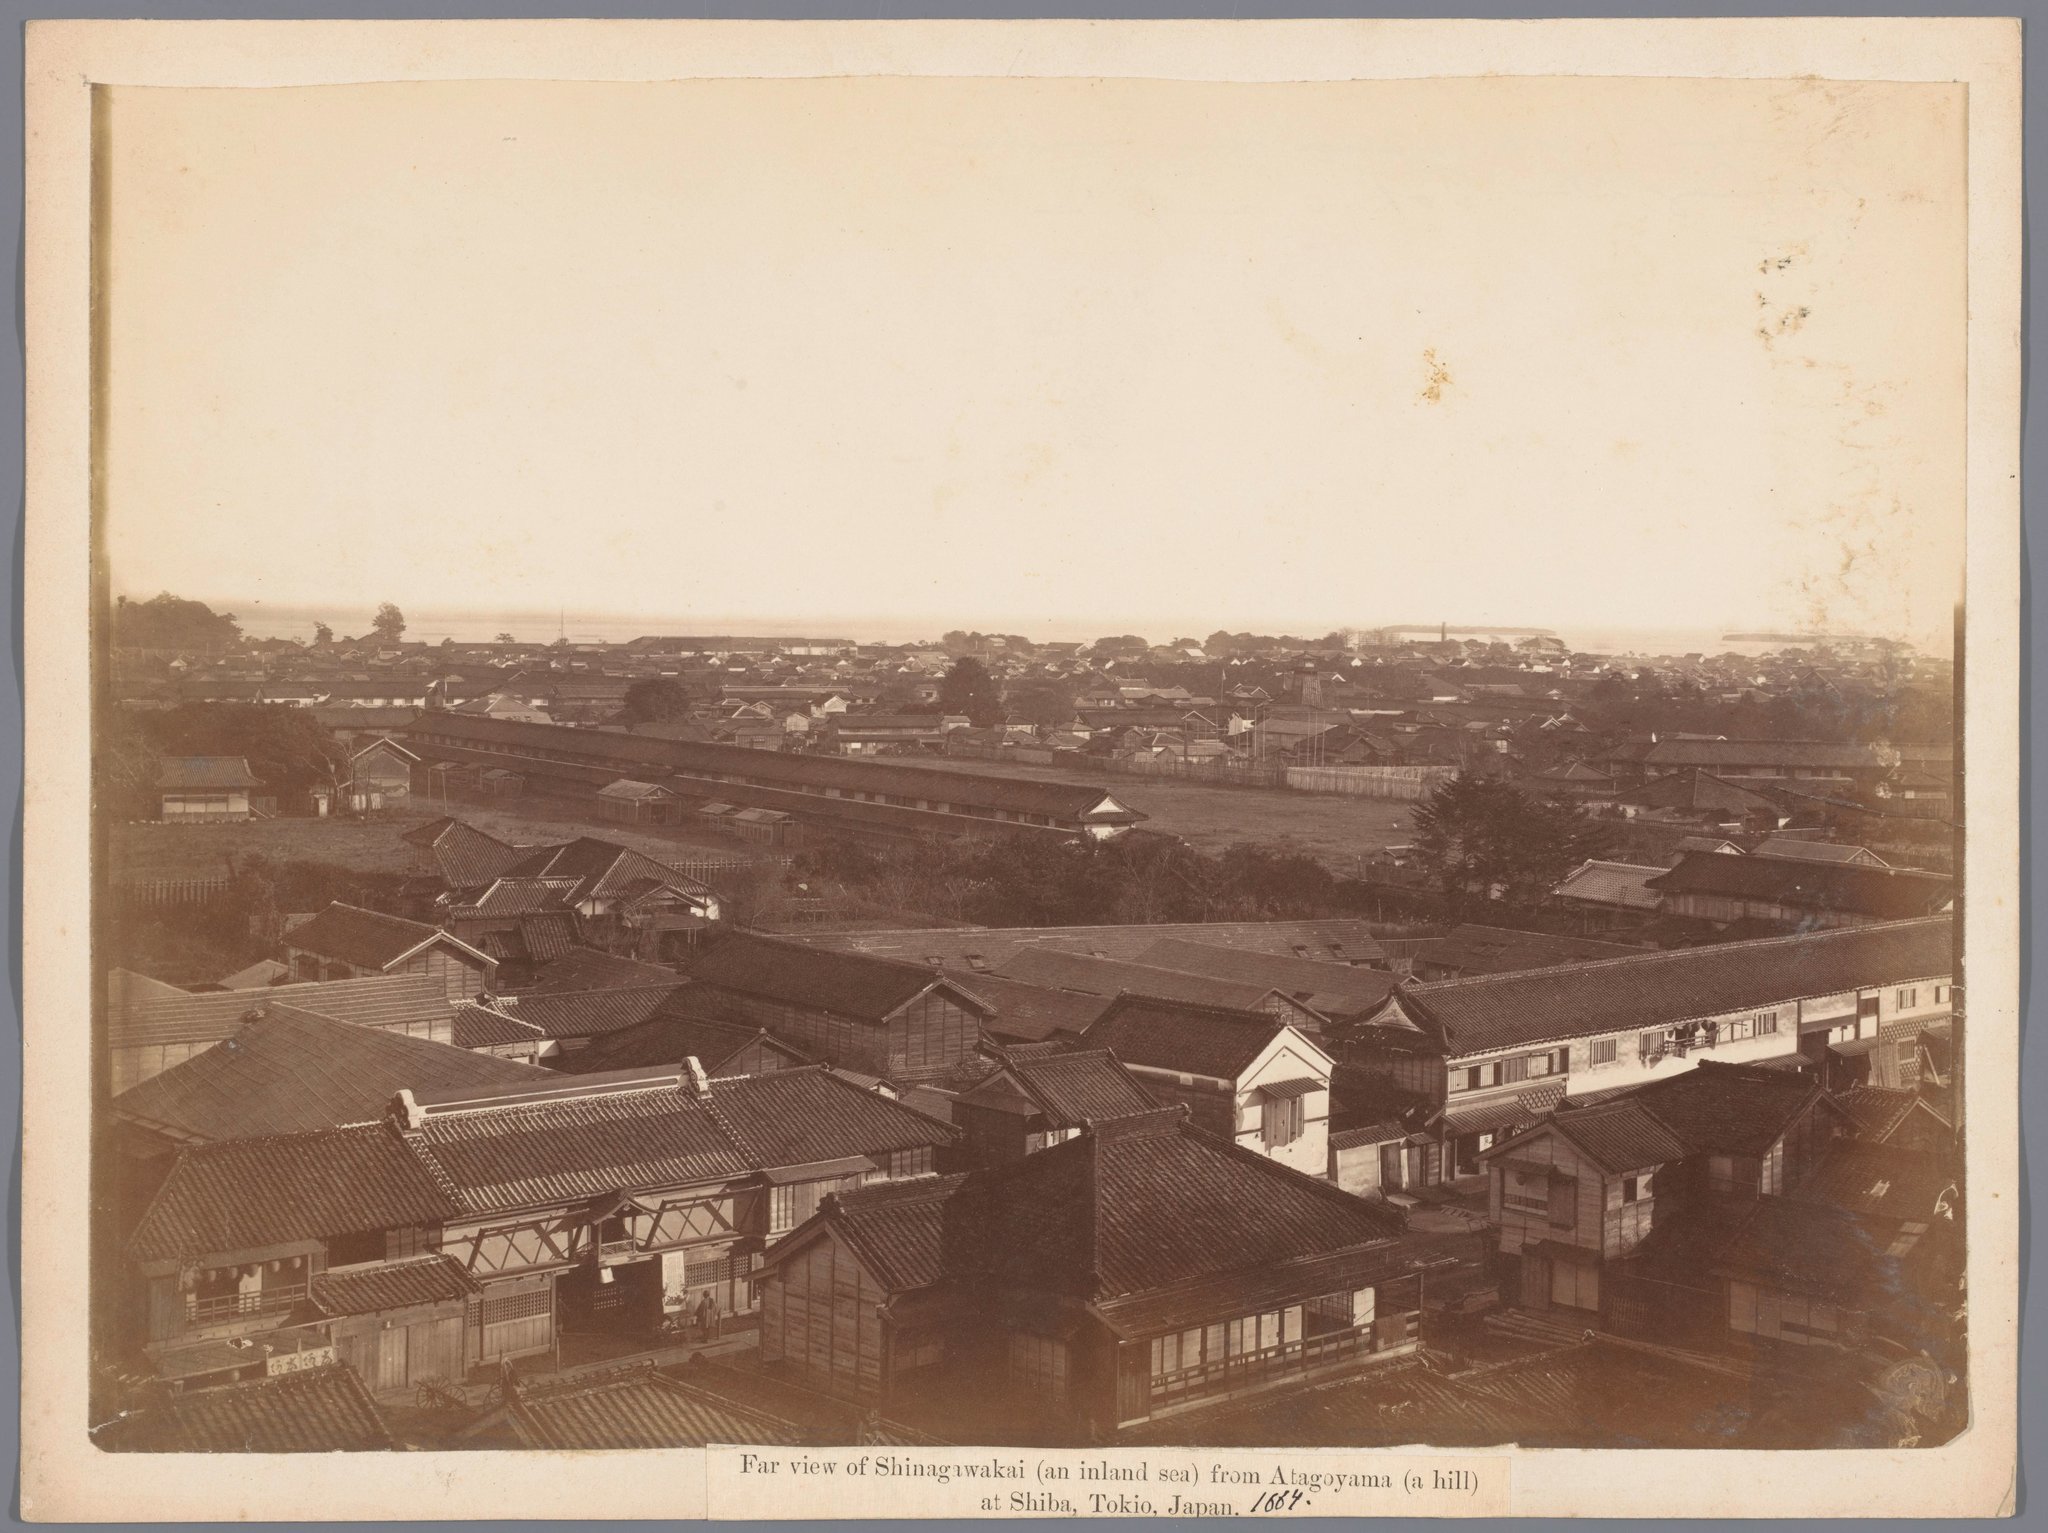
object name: photograph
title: Far view of Shinagawakai (an inland sea) from Atagoyama (a hill) at Shiba, Tokio, Japan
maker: Anonymous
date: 1884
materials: cardboard, paper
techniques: albumen print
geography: tokyo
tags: city-view in general; 'veduta'